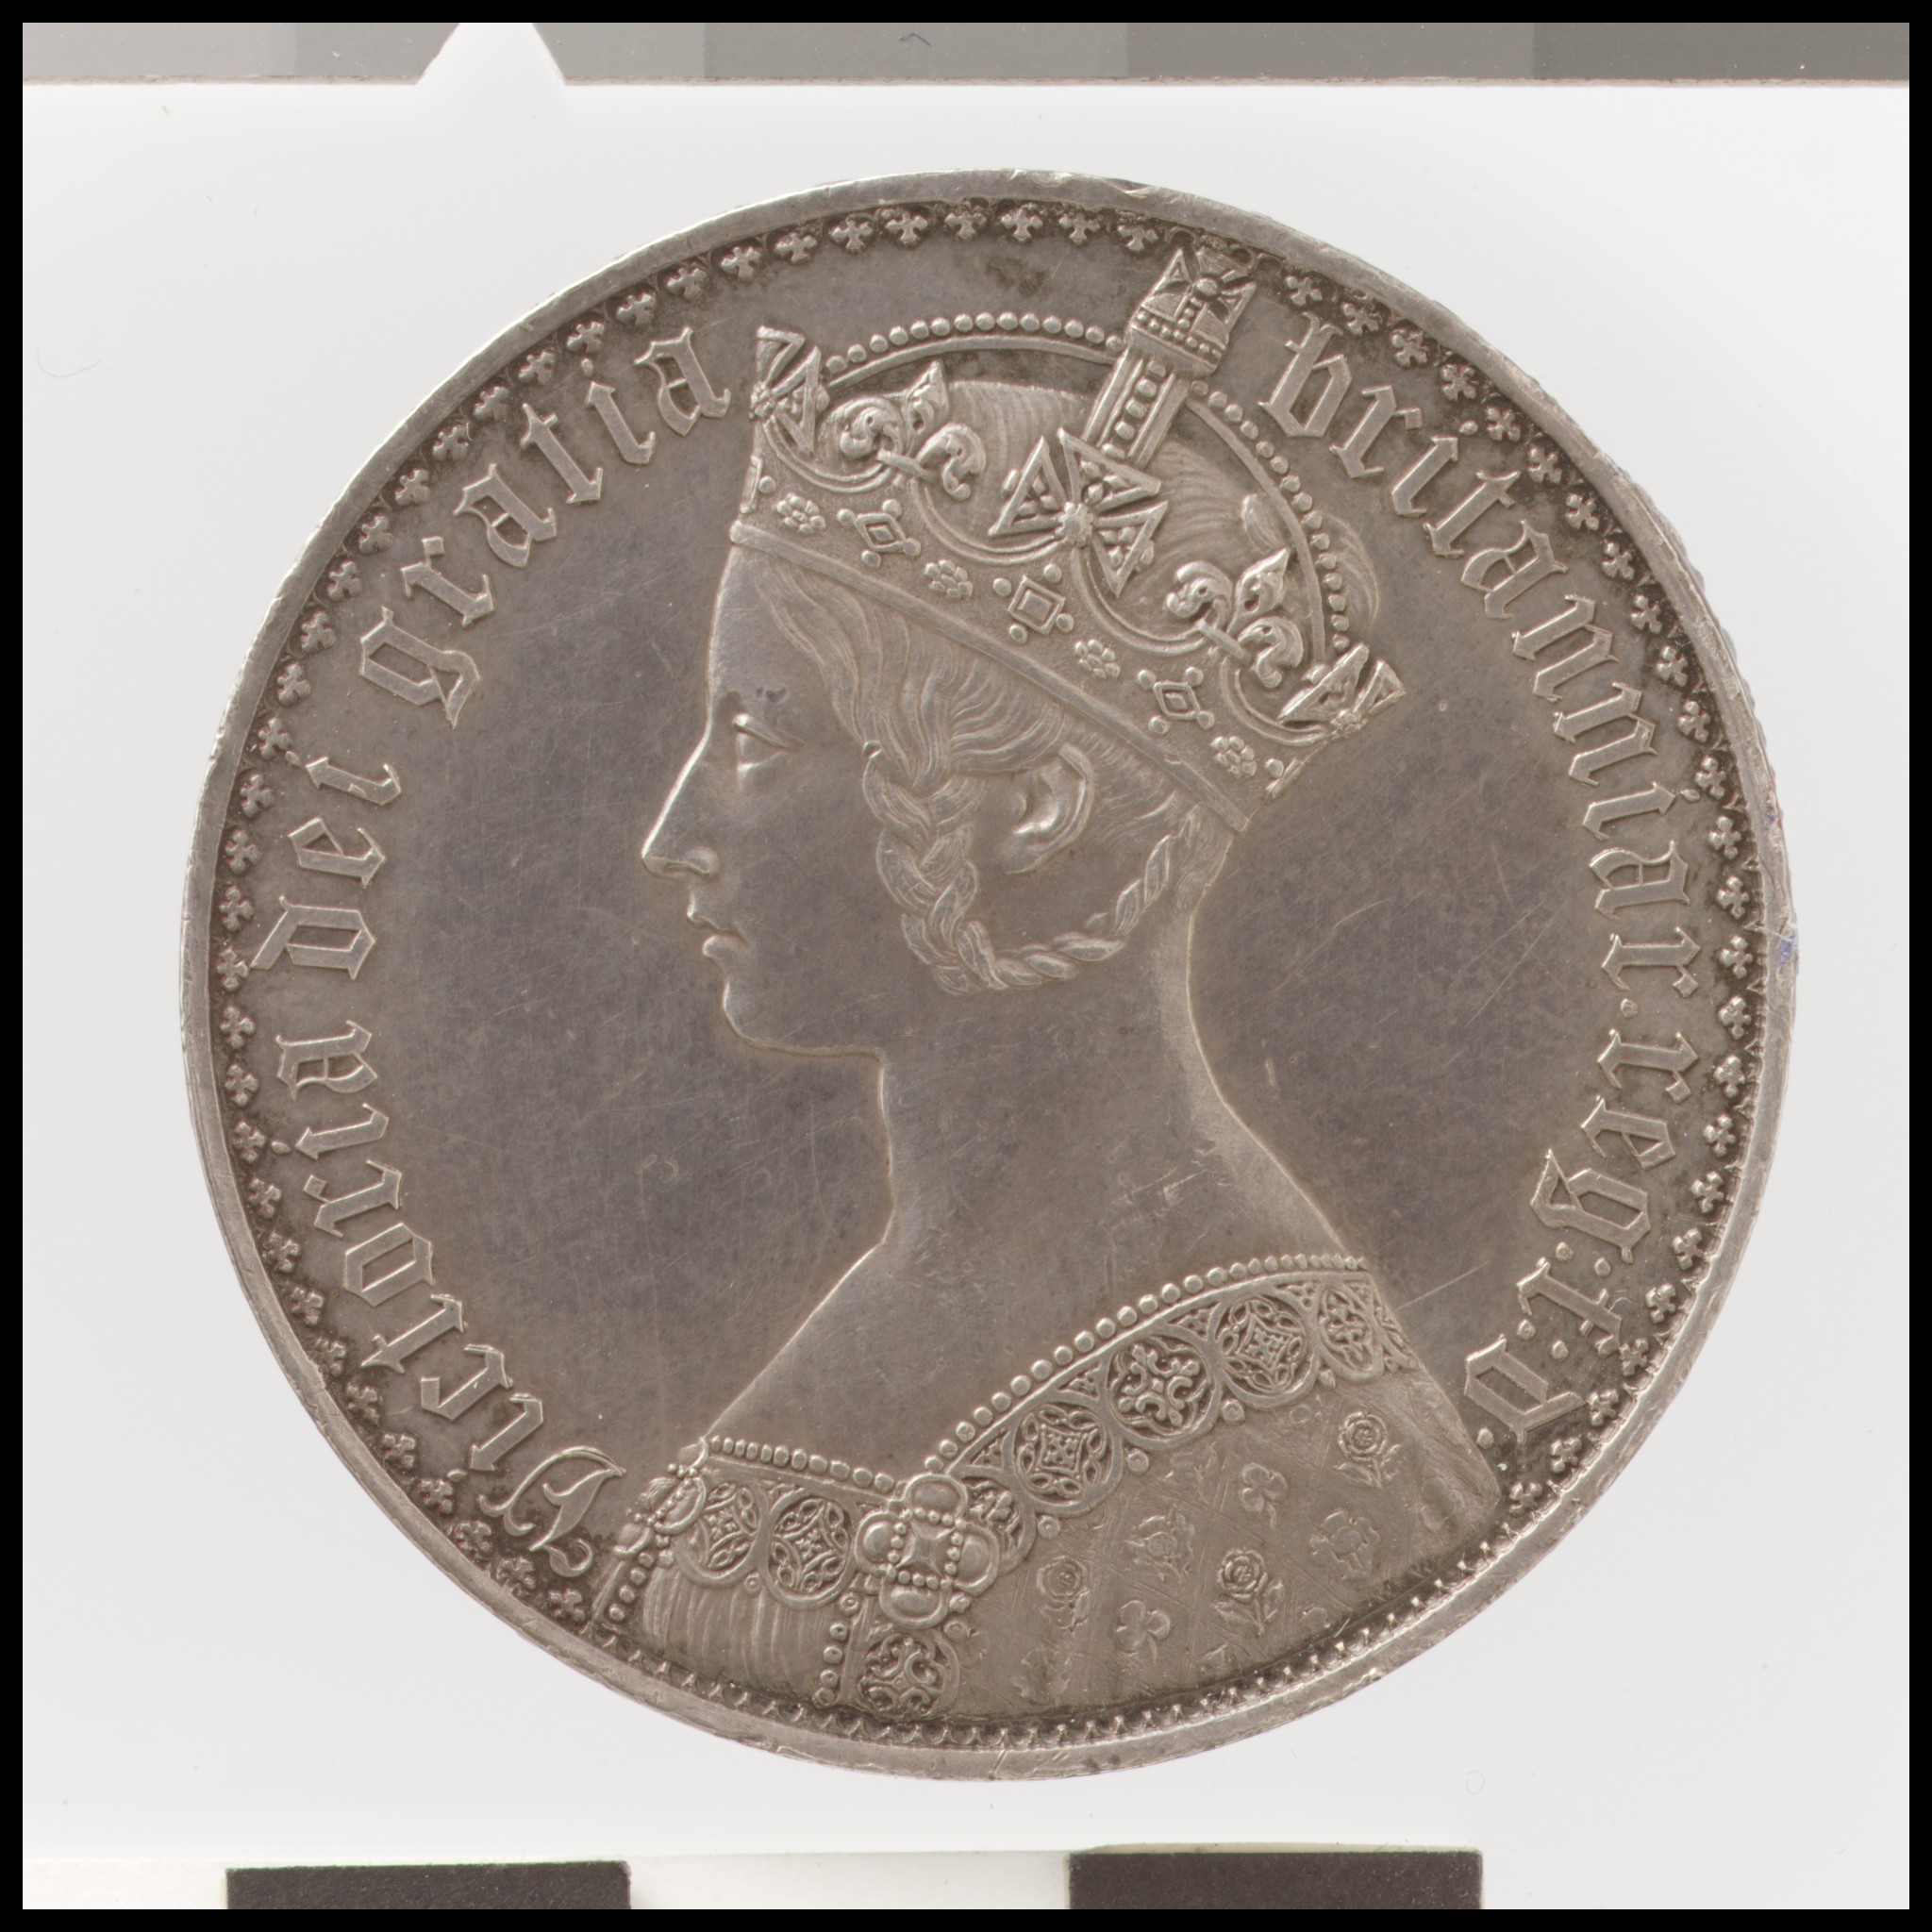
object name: crown coin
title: Victoria "Gothic" crown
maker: william wyon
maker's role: artist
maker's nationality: british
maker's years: 1795-1851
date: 1847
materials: silver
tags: queens,profiles,coat of arms